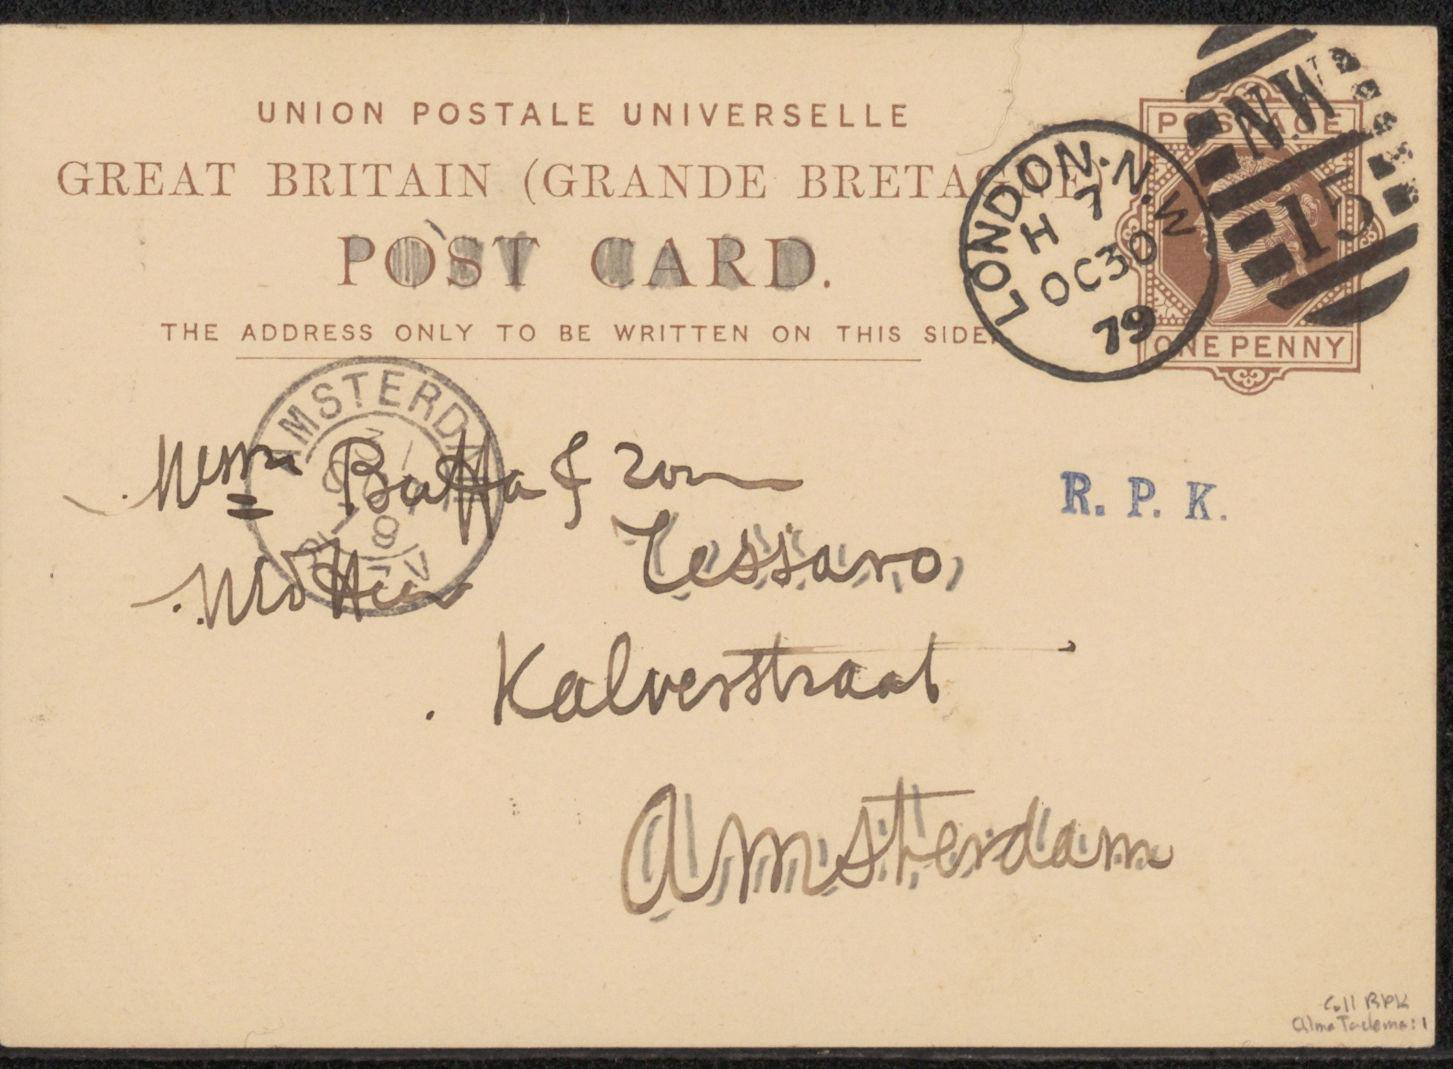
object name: postcard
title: Briefkaart aan Frans Buffa en Zonen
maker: lourens alma tadema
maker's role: draughtsman, print maker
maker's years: 1836-1912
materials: cardboard, ink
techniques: pen, writing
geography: london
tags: amsterdam, publisher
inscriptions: collector's mark: Lugt 2233